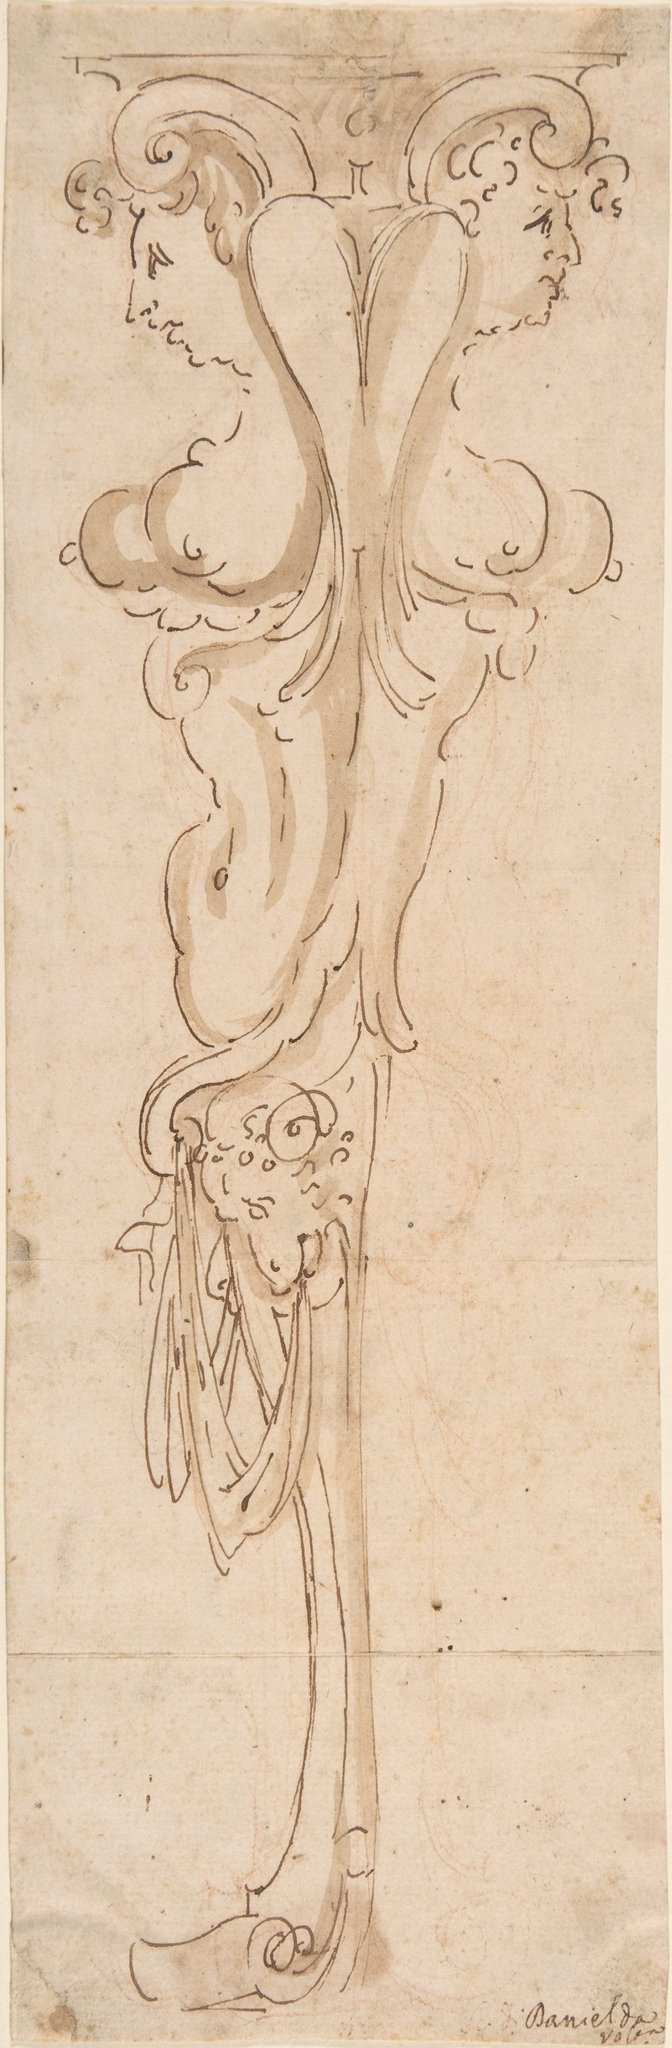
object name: drawing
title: Architectural detail with Female Figures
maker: anonymous, italian, 17th century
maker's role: artist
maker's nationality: italian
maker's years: 1600-1700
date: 1601-1700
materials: chalk, ink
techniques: brush, pen, wash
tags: caryatids